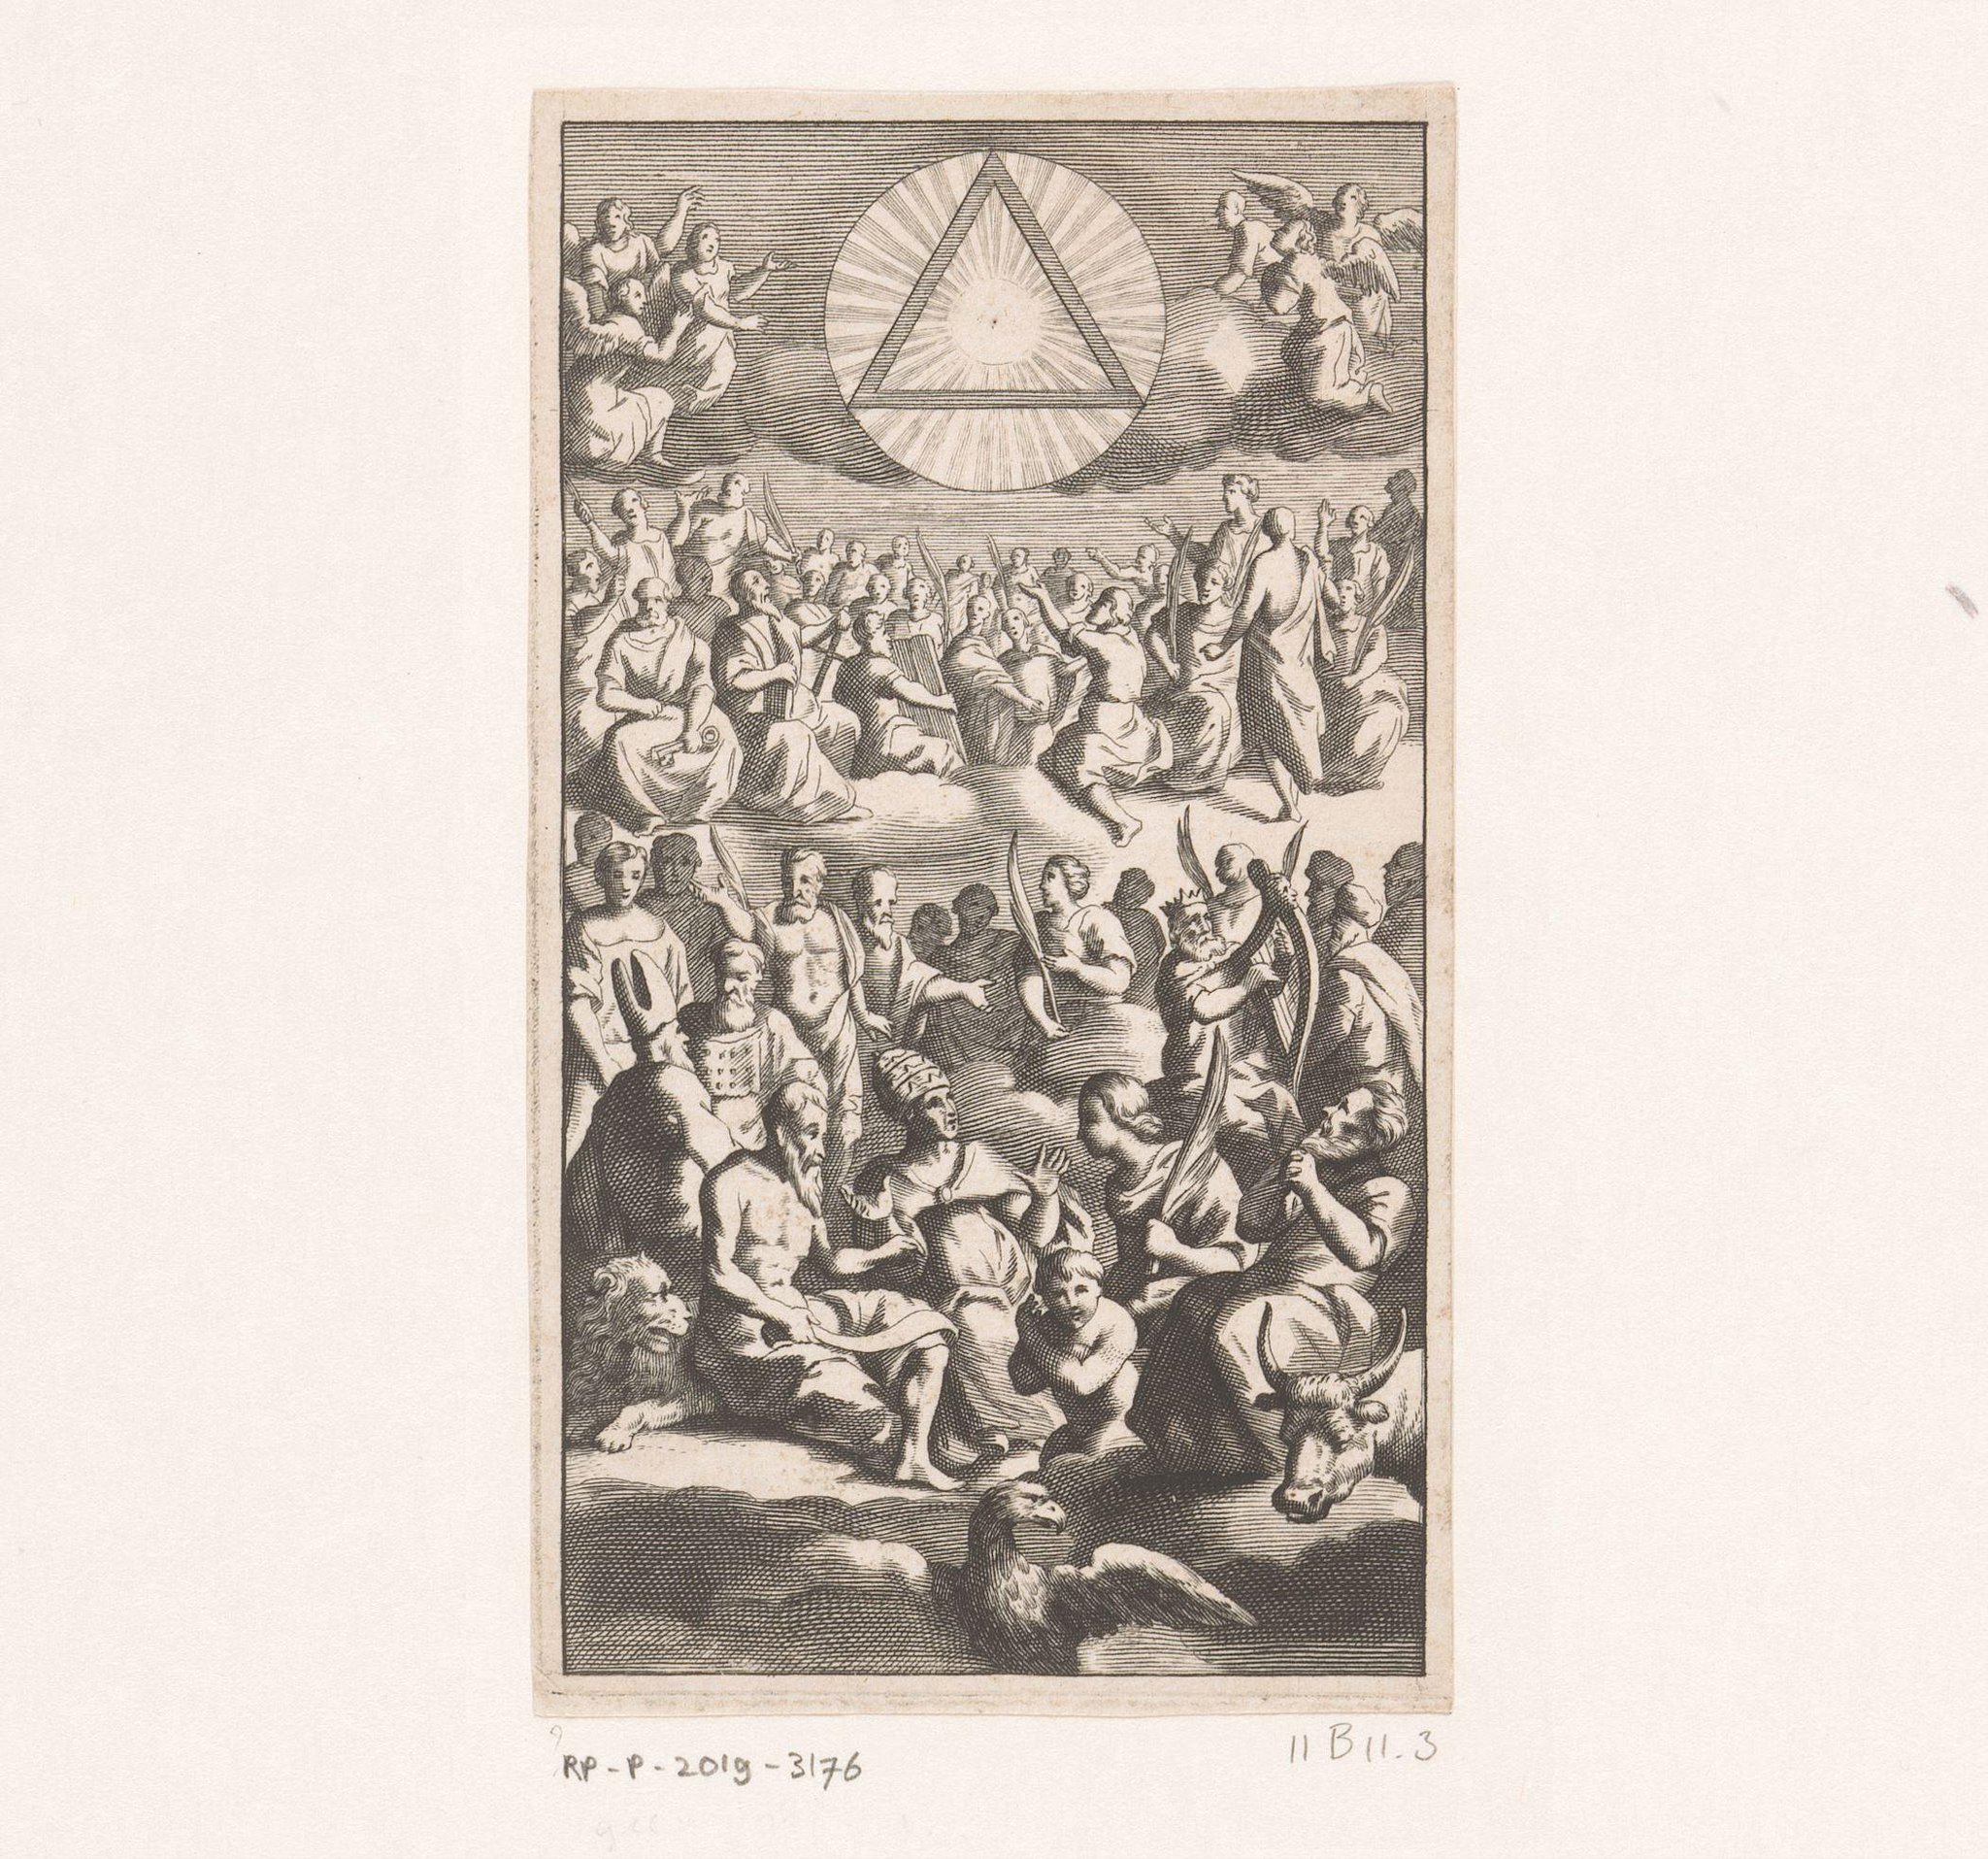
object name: print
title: Aanbidding van de Heilige Drie-eenheid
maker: Anonymous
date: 1700-1799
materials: paper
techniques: engraving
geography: netherlands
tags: triangle (within circle), with eye or tetragram ~ trinity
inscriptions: collector's mark: Lugt 2228